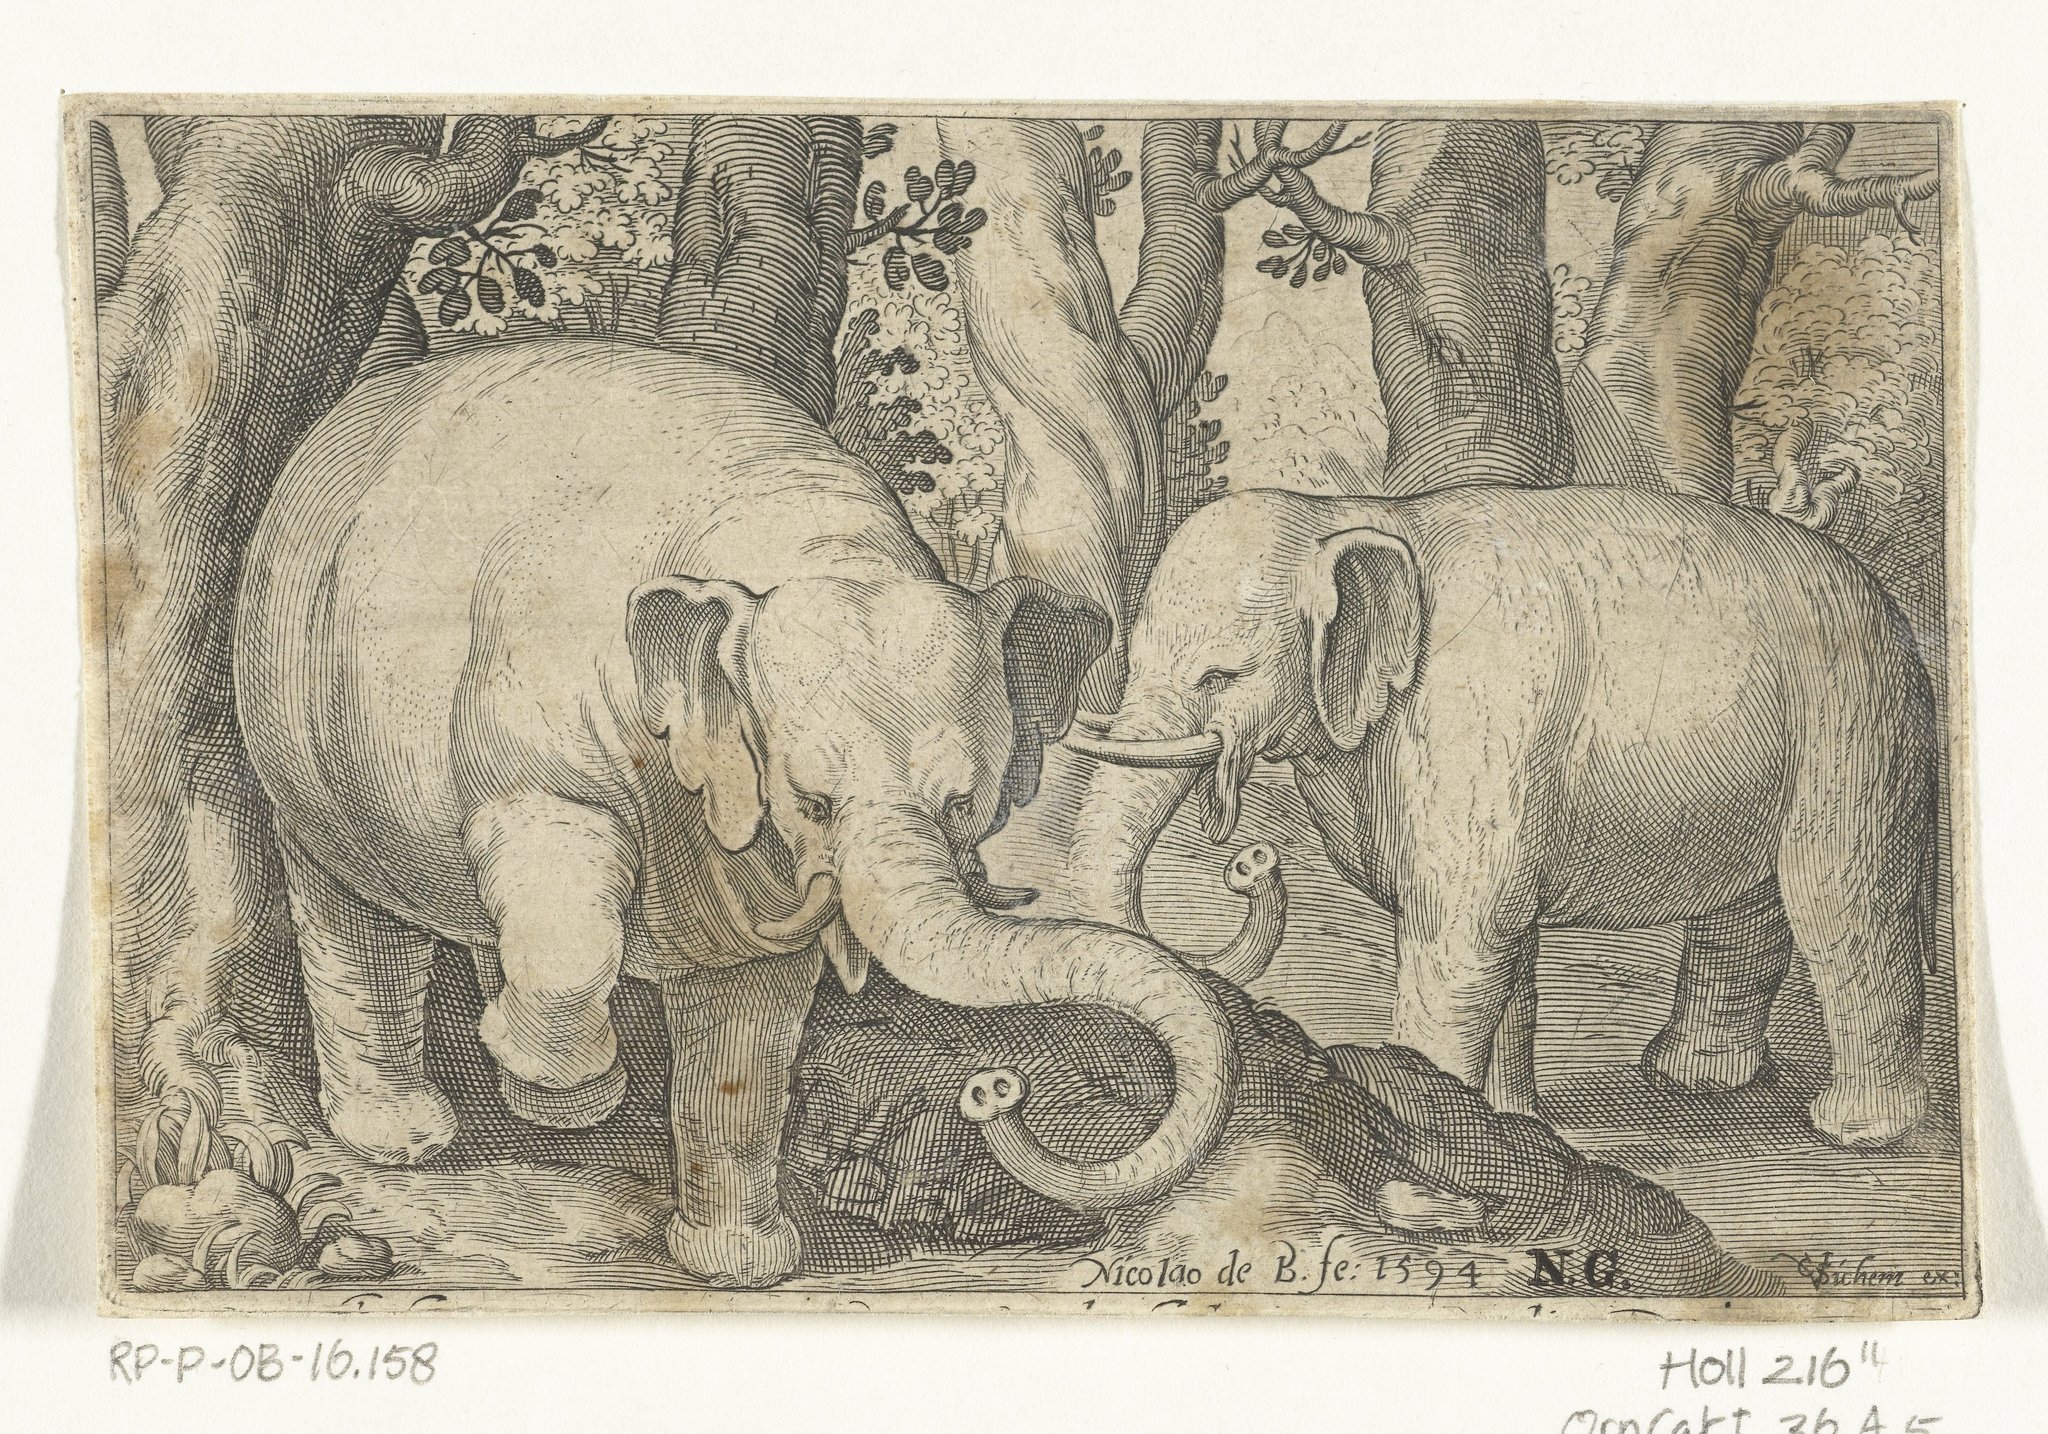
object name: print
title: Dieren in landschappen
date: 1594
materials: paper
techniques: engraving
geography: netherlands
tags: trunked animals: elephant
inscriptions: collector's mark: Lugt 2228, collector's mark: Lugt 1967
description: Prent uit serie Animalivm qvadrvpedvm van twaalf prenten met dieren (viervoeters) in landschappen. Hollstein beschrijft twee staten, als eerste staat een uitgave van Assuerus van Londerseel voor de nummering (gedateerd 1594) en als tweede staat een uitgave van Claes Jansz. Visscher (II) met nummering (gedateerd 1621). Er is echter nog een andere editie bekend van uitgever Christoffel van Sichem welke tussen deze twee staten in geplaatst kan worden. Verschillende drukken van Visscher vertonen nog sporen van een adres van Van Sichem, op het hier beschreven blad staat zijn adres. De marge met het adres van Londerseel is verwijderd waardoor de plaat een stuk kleiner is. De editie van Visscher is gedrukt van zeer versleten platen, zie De Groot 1988, p. 36, 37.